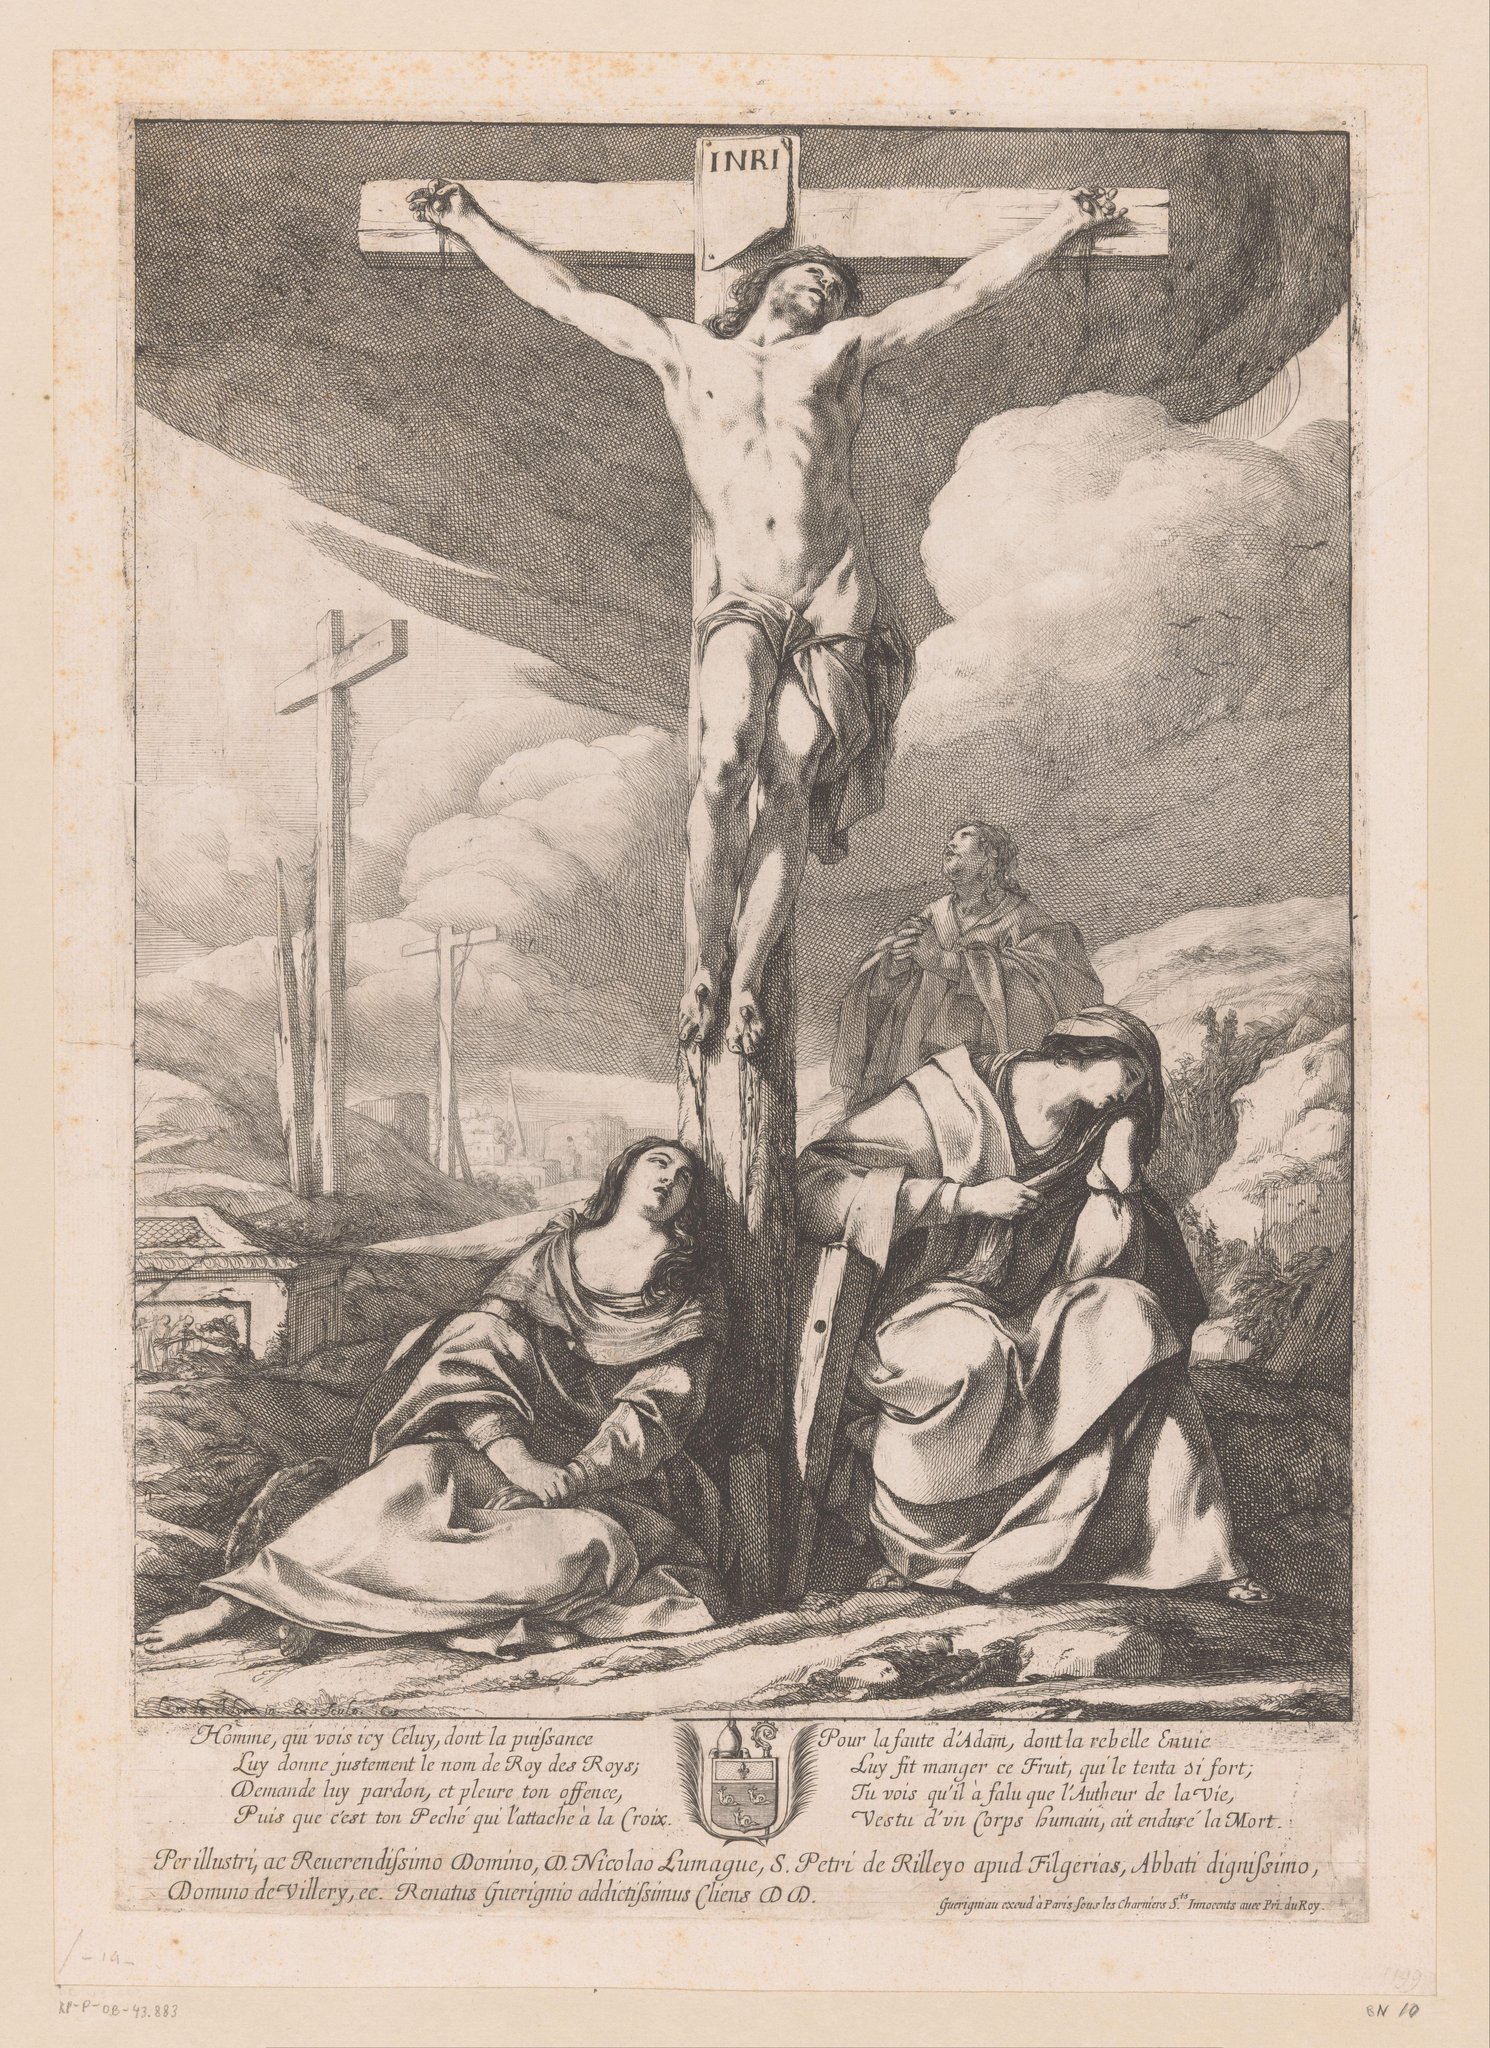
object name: print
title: Kruisiging van Christus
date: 1639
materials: paper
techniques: engraving, etching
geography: france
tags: the crucifixion of christ: christ's death on the cross; golgotha (matthew 27:45-58; mark 15:33-45; luke 23:44-52; john 19:25-38)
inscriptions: collector's mark: Lugt 240, watermark